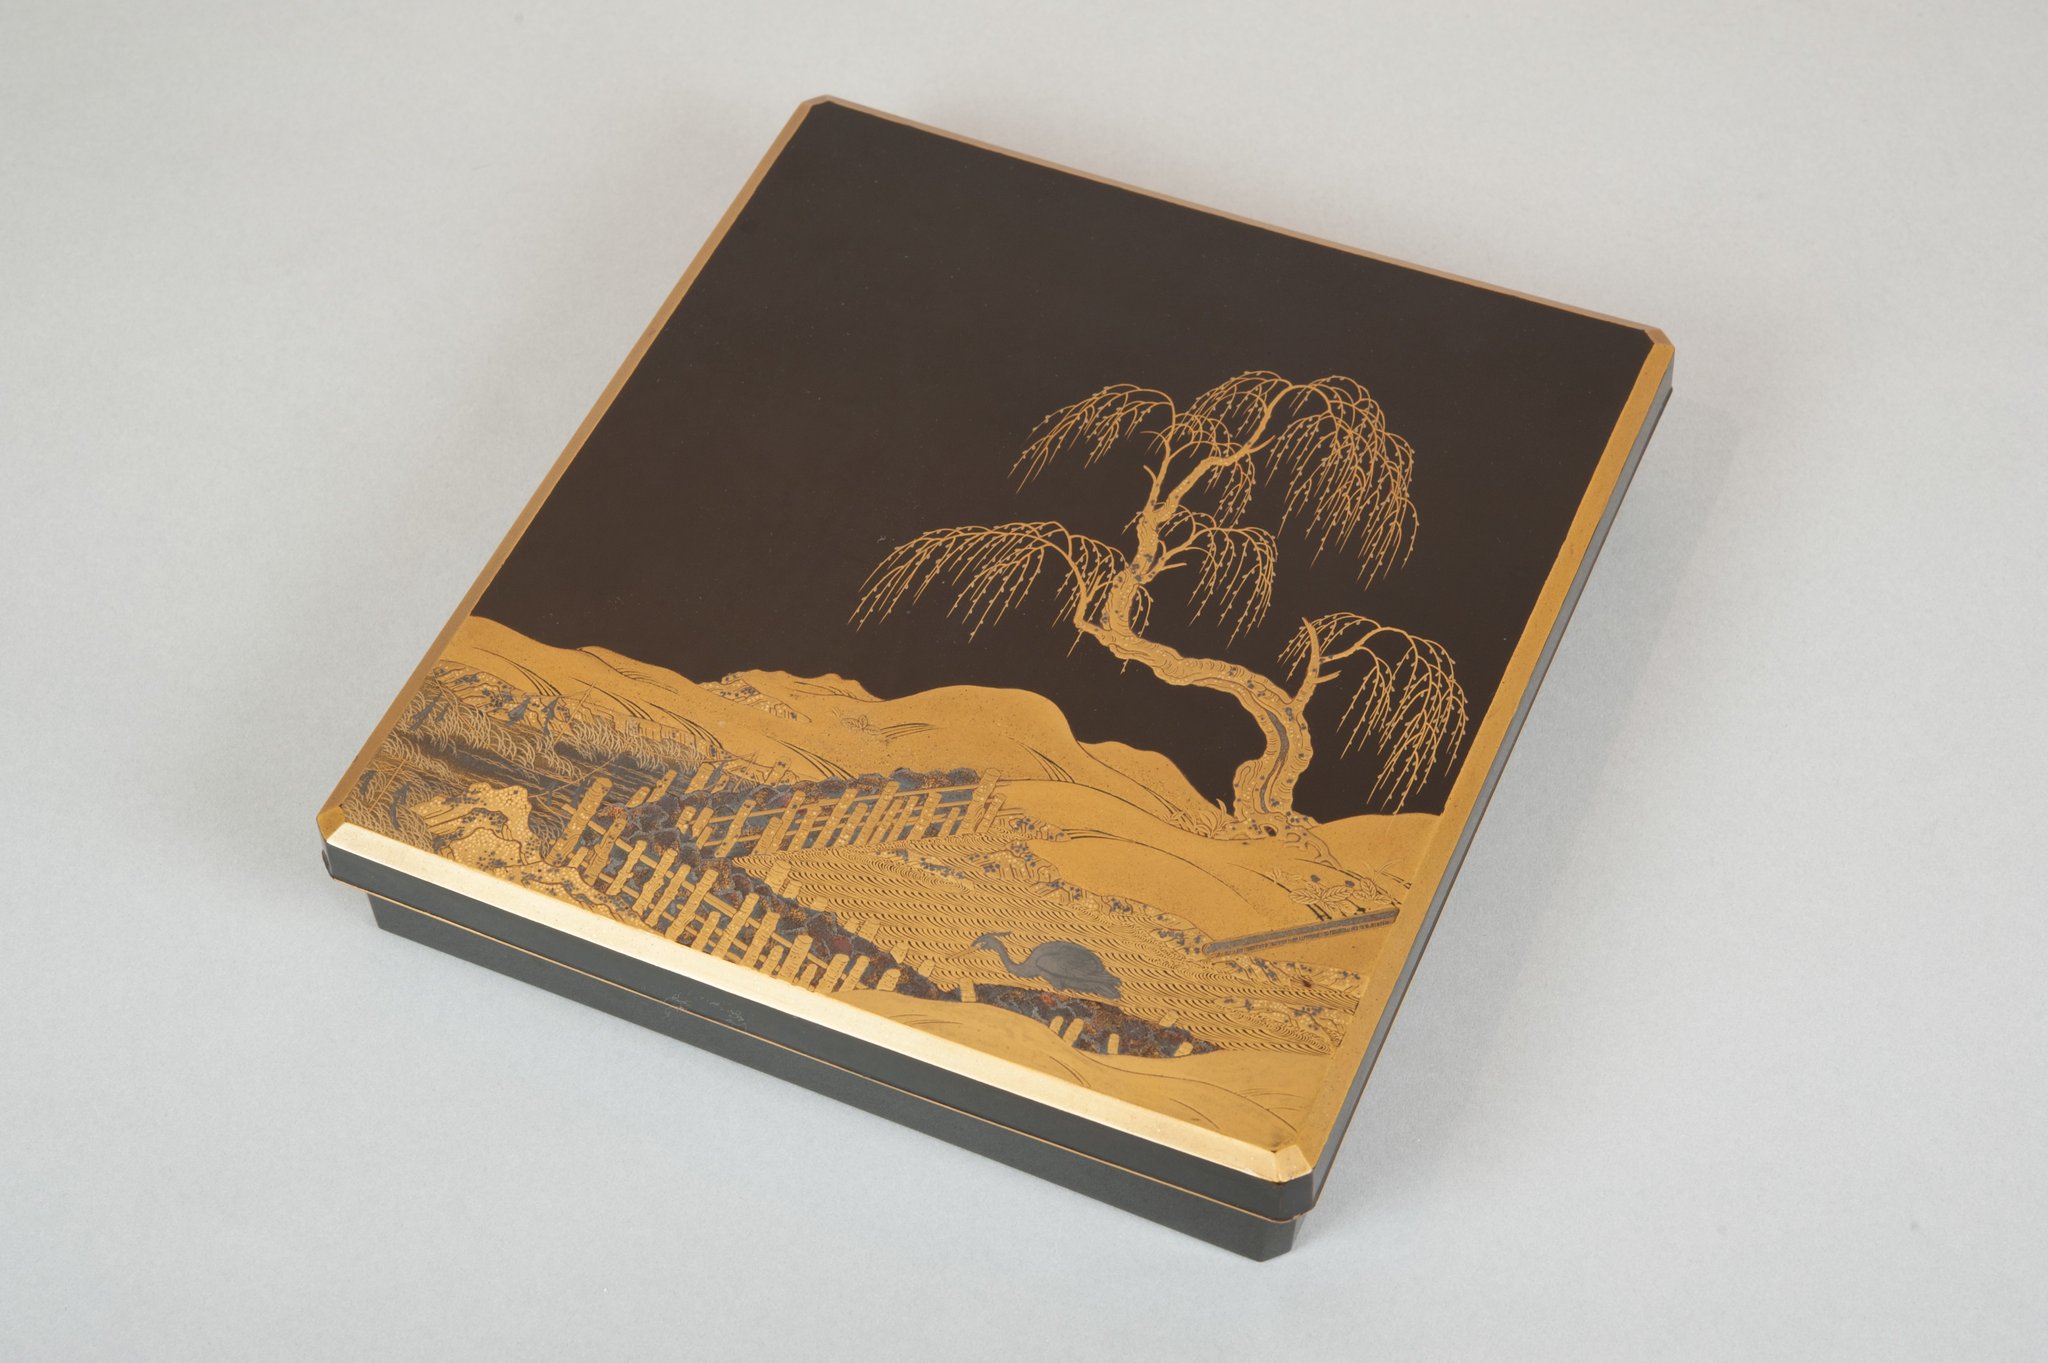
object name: writing box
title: Writing Box (Suzuribako) with Landscape Design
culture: japanese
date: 1801-1900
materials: foil, gold, lacquer, silver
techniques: maki-e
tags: birds,landscapes,trees